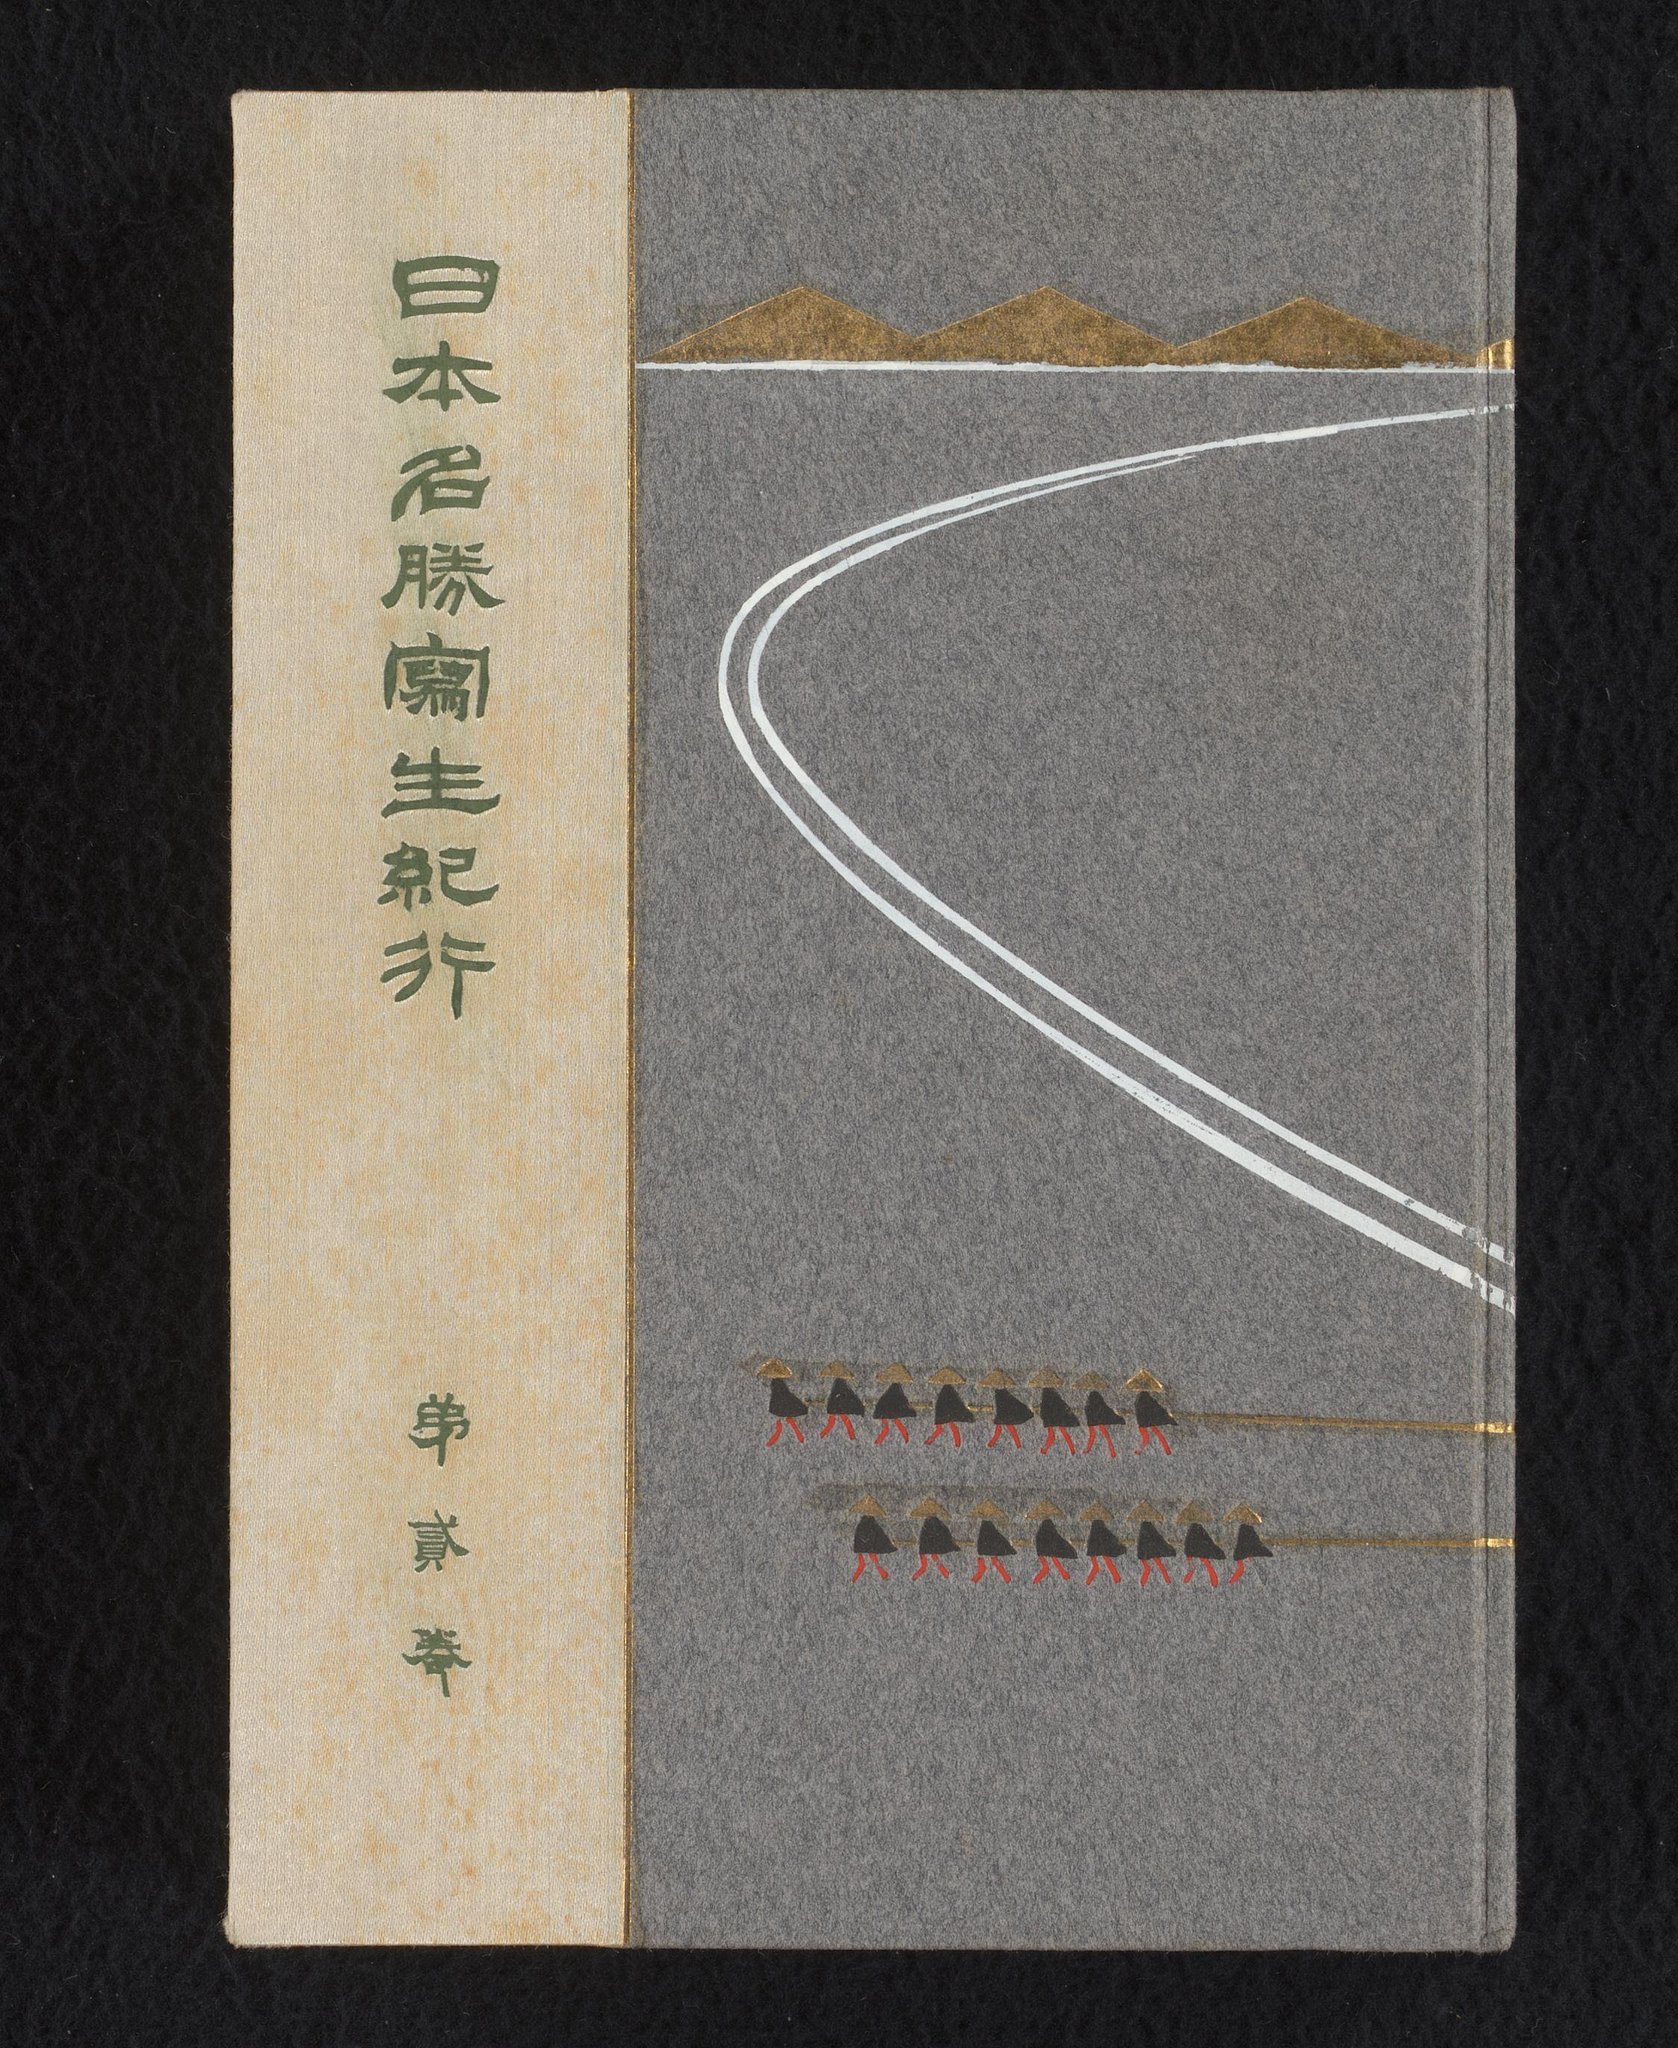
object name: book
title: Nihon meishô shasei kikô - dai ni shû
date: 1908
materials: paper